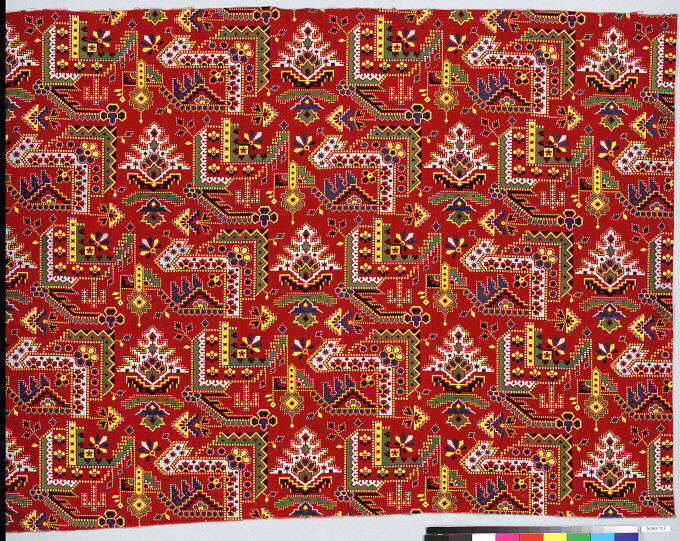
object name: piece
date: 1867-1900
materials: cotton